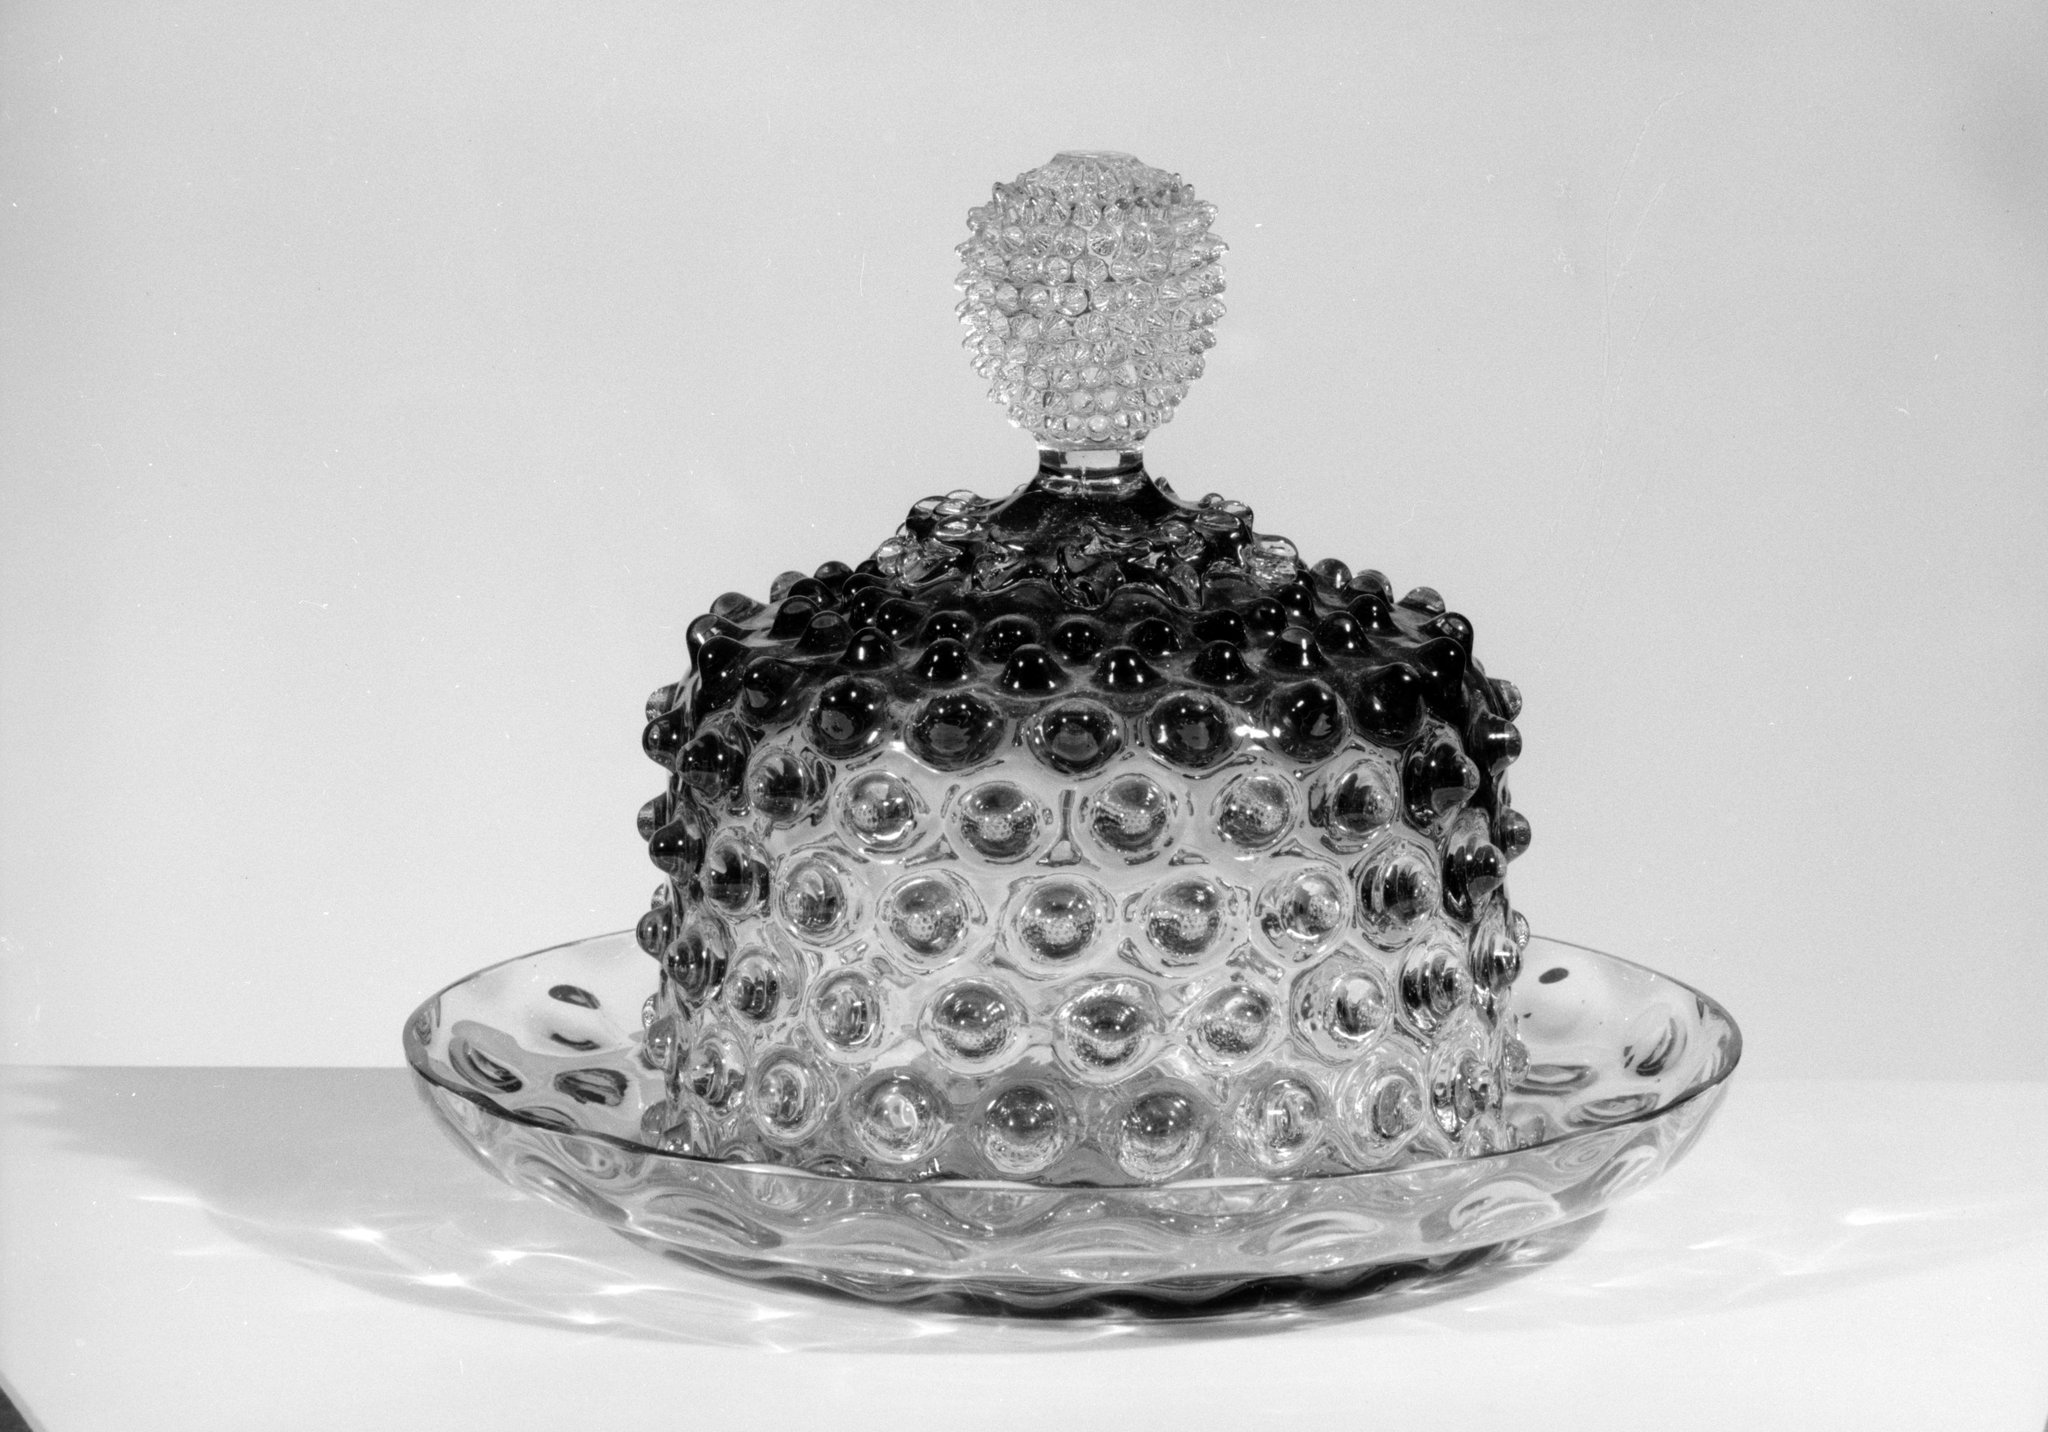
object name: cheese dish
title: Hobnail Cheese Dish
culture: american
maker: hobbs, brockunier and company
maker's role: maker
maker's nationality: american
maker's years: 1863-1891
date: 1886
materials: glass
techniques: pressed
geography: united states